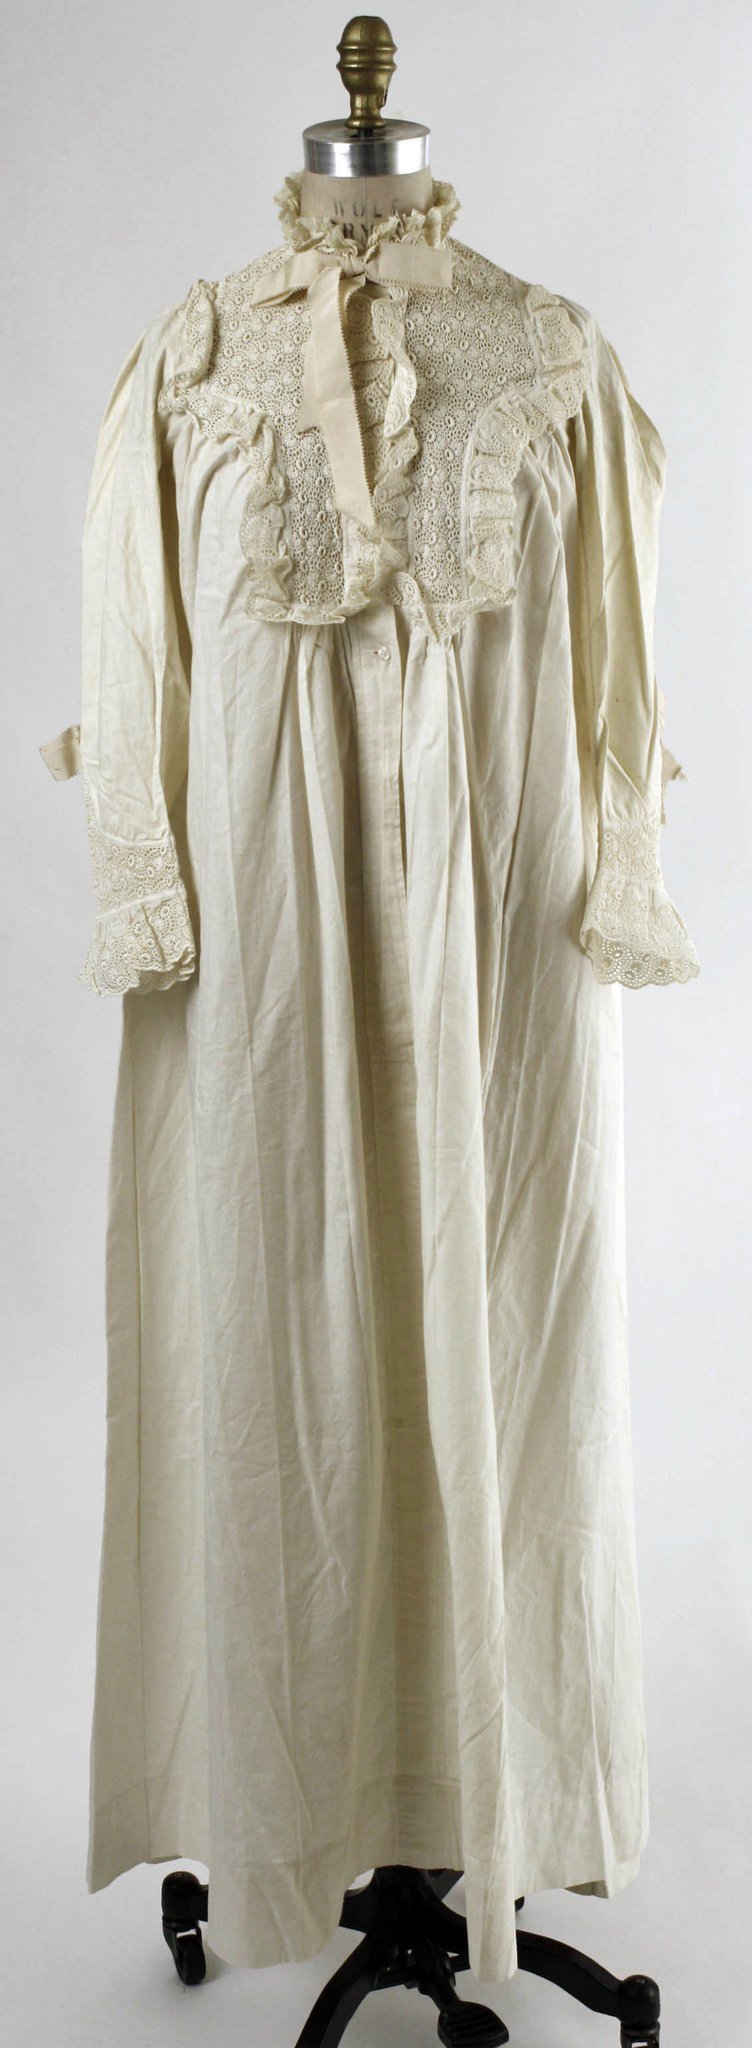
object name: lingerie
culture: american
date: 1887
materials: cotton